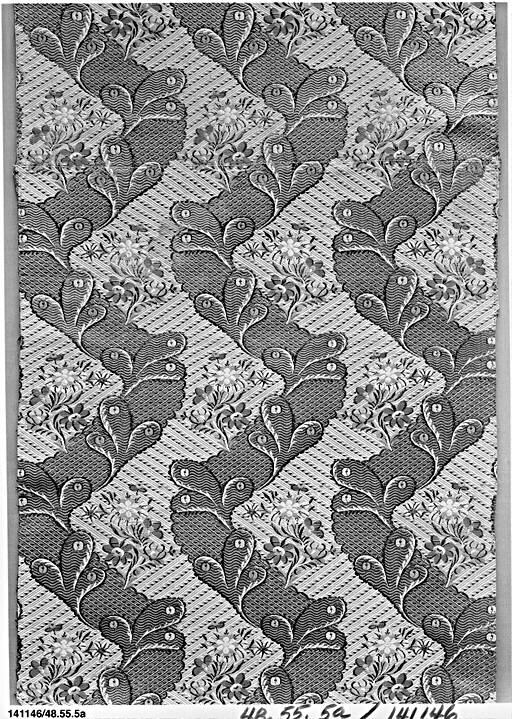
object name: piece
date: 1760-1770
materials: silk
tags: flowers